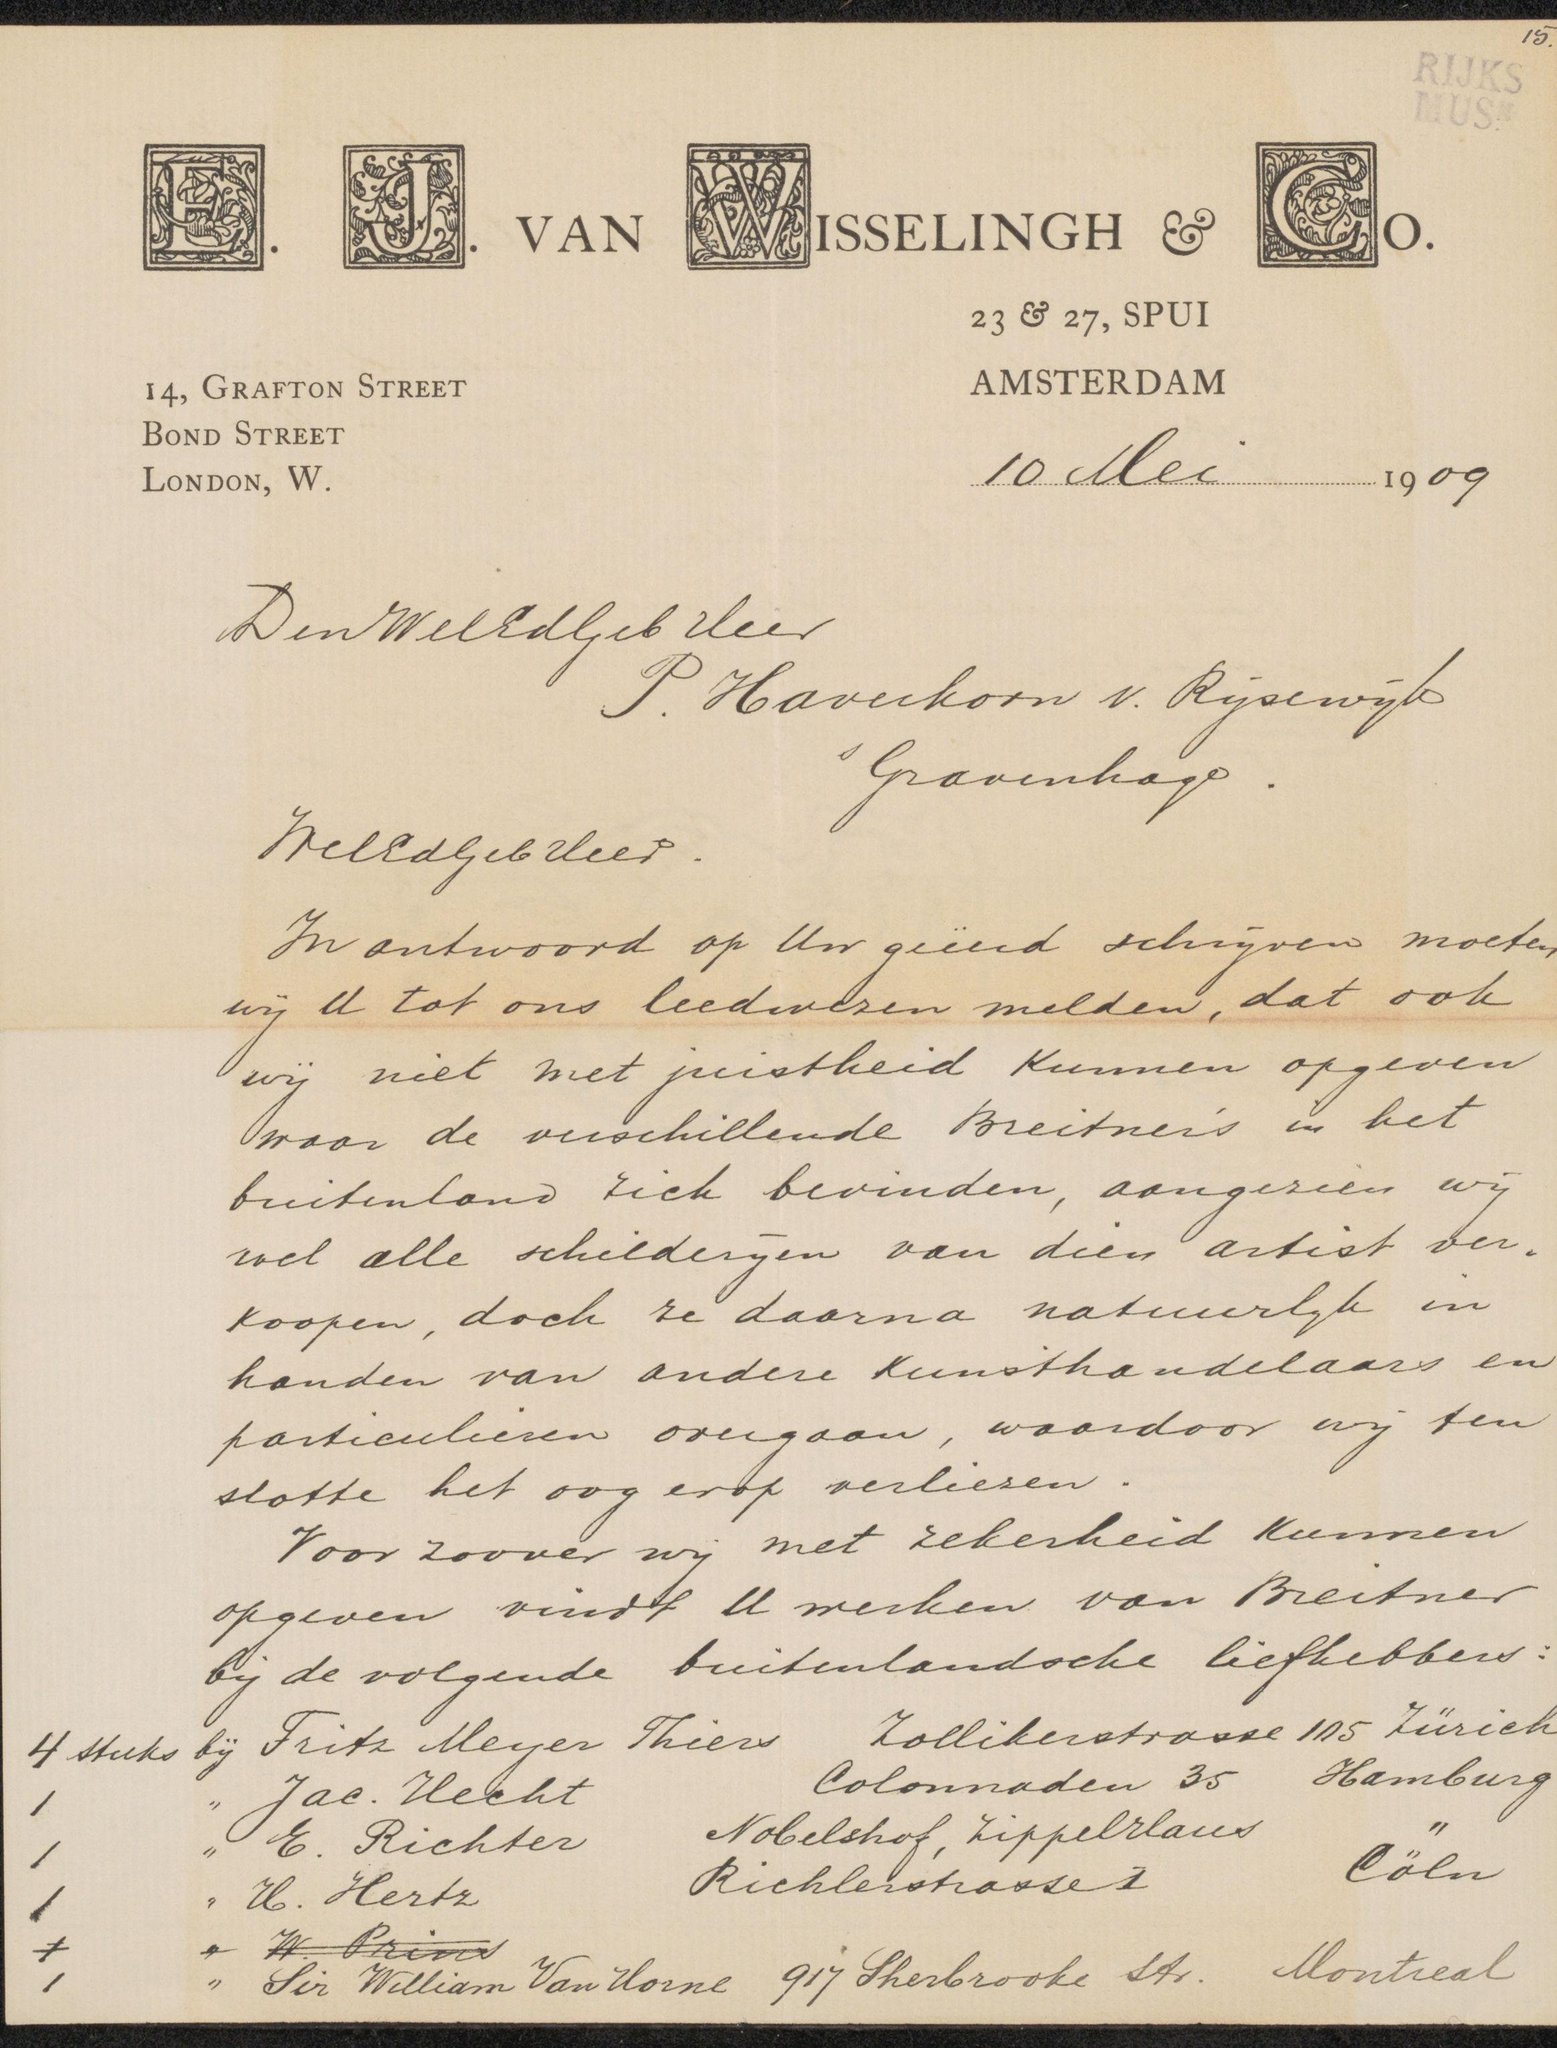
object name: letter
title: Brief aan Pieter Haverkorn van Rijsewijk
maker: willem bloemkolk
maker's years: 1879-1933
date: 1909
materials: ink, paper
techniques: pen, printing, writing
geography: amsterdam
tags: auctioneer, e. richter, rotterdam, amsterdam, painter, draughtsman, george hendrik breitner, pieter haverkorn van rijsewijk, painting (including book-illumination, miniature-painting)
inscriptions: watermark, collector's mark: Lugt 2166